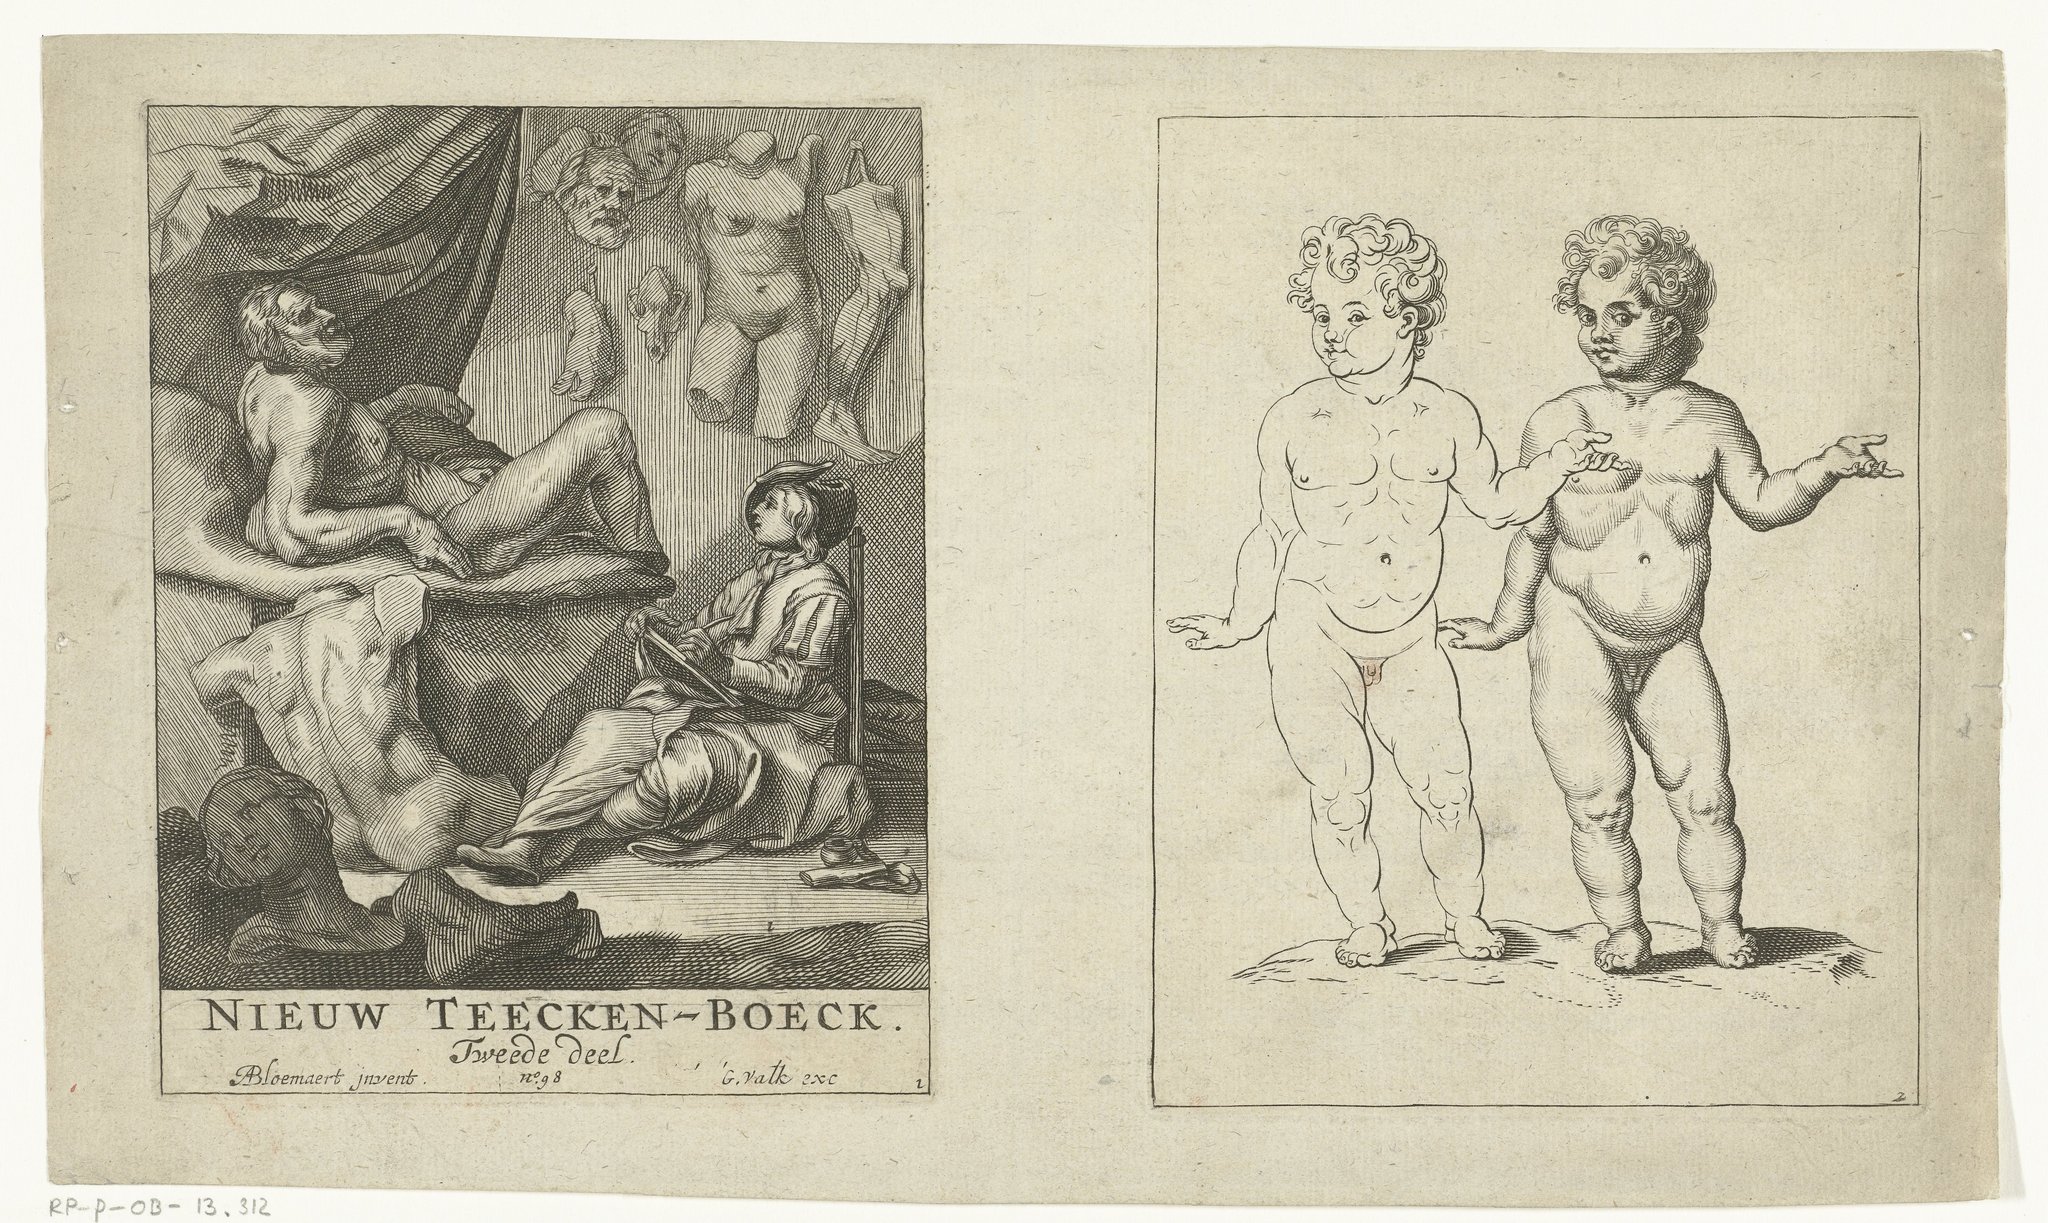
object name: print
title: Nieuw teecken-boeck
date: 1671-1726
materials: paper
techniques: engraving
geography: amsterdam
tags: title-page, drawing-lesson, cupids: 'amores', 'amoretti', 'putti'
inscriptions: collector's mark: Lugt 2228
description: Niet versneden blad met twee voorstellingen. Links, een zittende jonge man tekent een sculptuur na. Rechts op hetzelfde vel, een studie van twee staande mollige putti. Links in contour, rechts met arceringen. Rechtsonder genummerd 1 en 2.